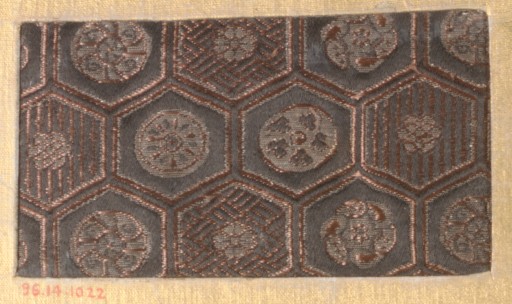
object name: piece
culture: japanese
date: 1701-1900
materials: silk